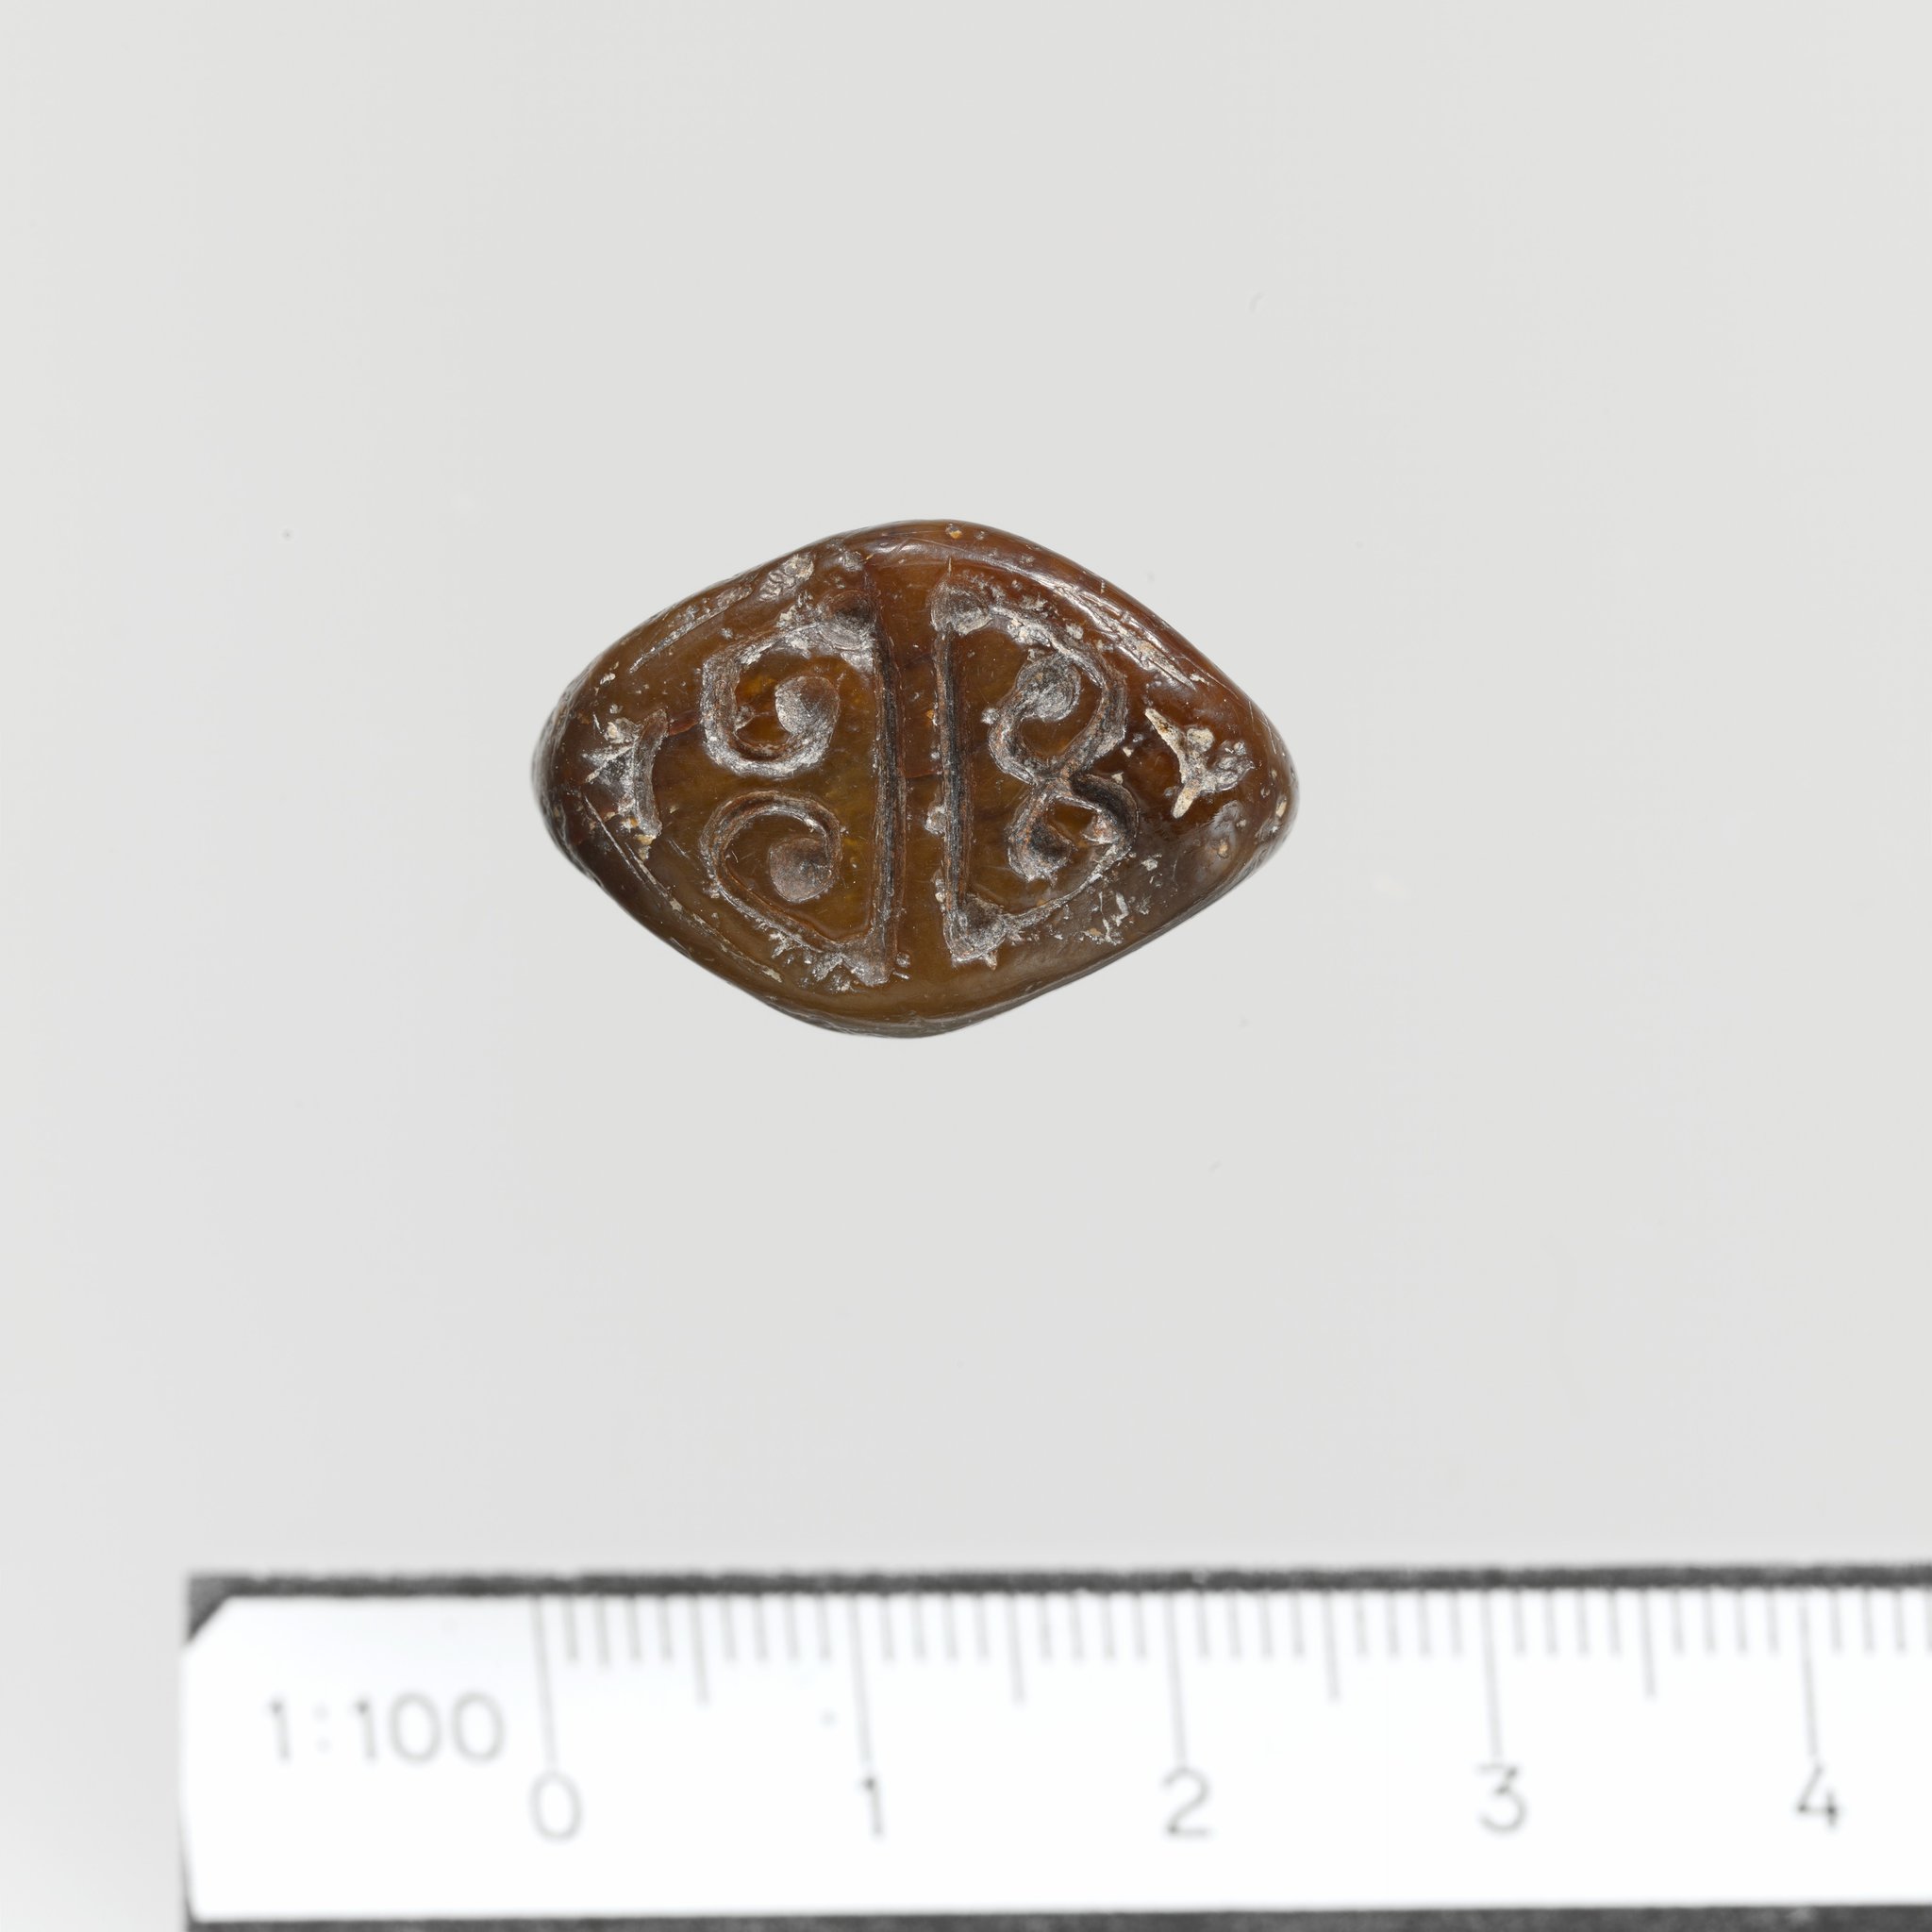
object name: seal, conoid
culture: minoan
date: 2200-1900 BCE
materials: stone